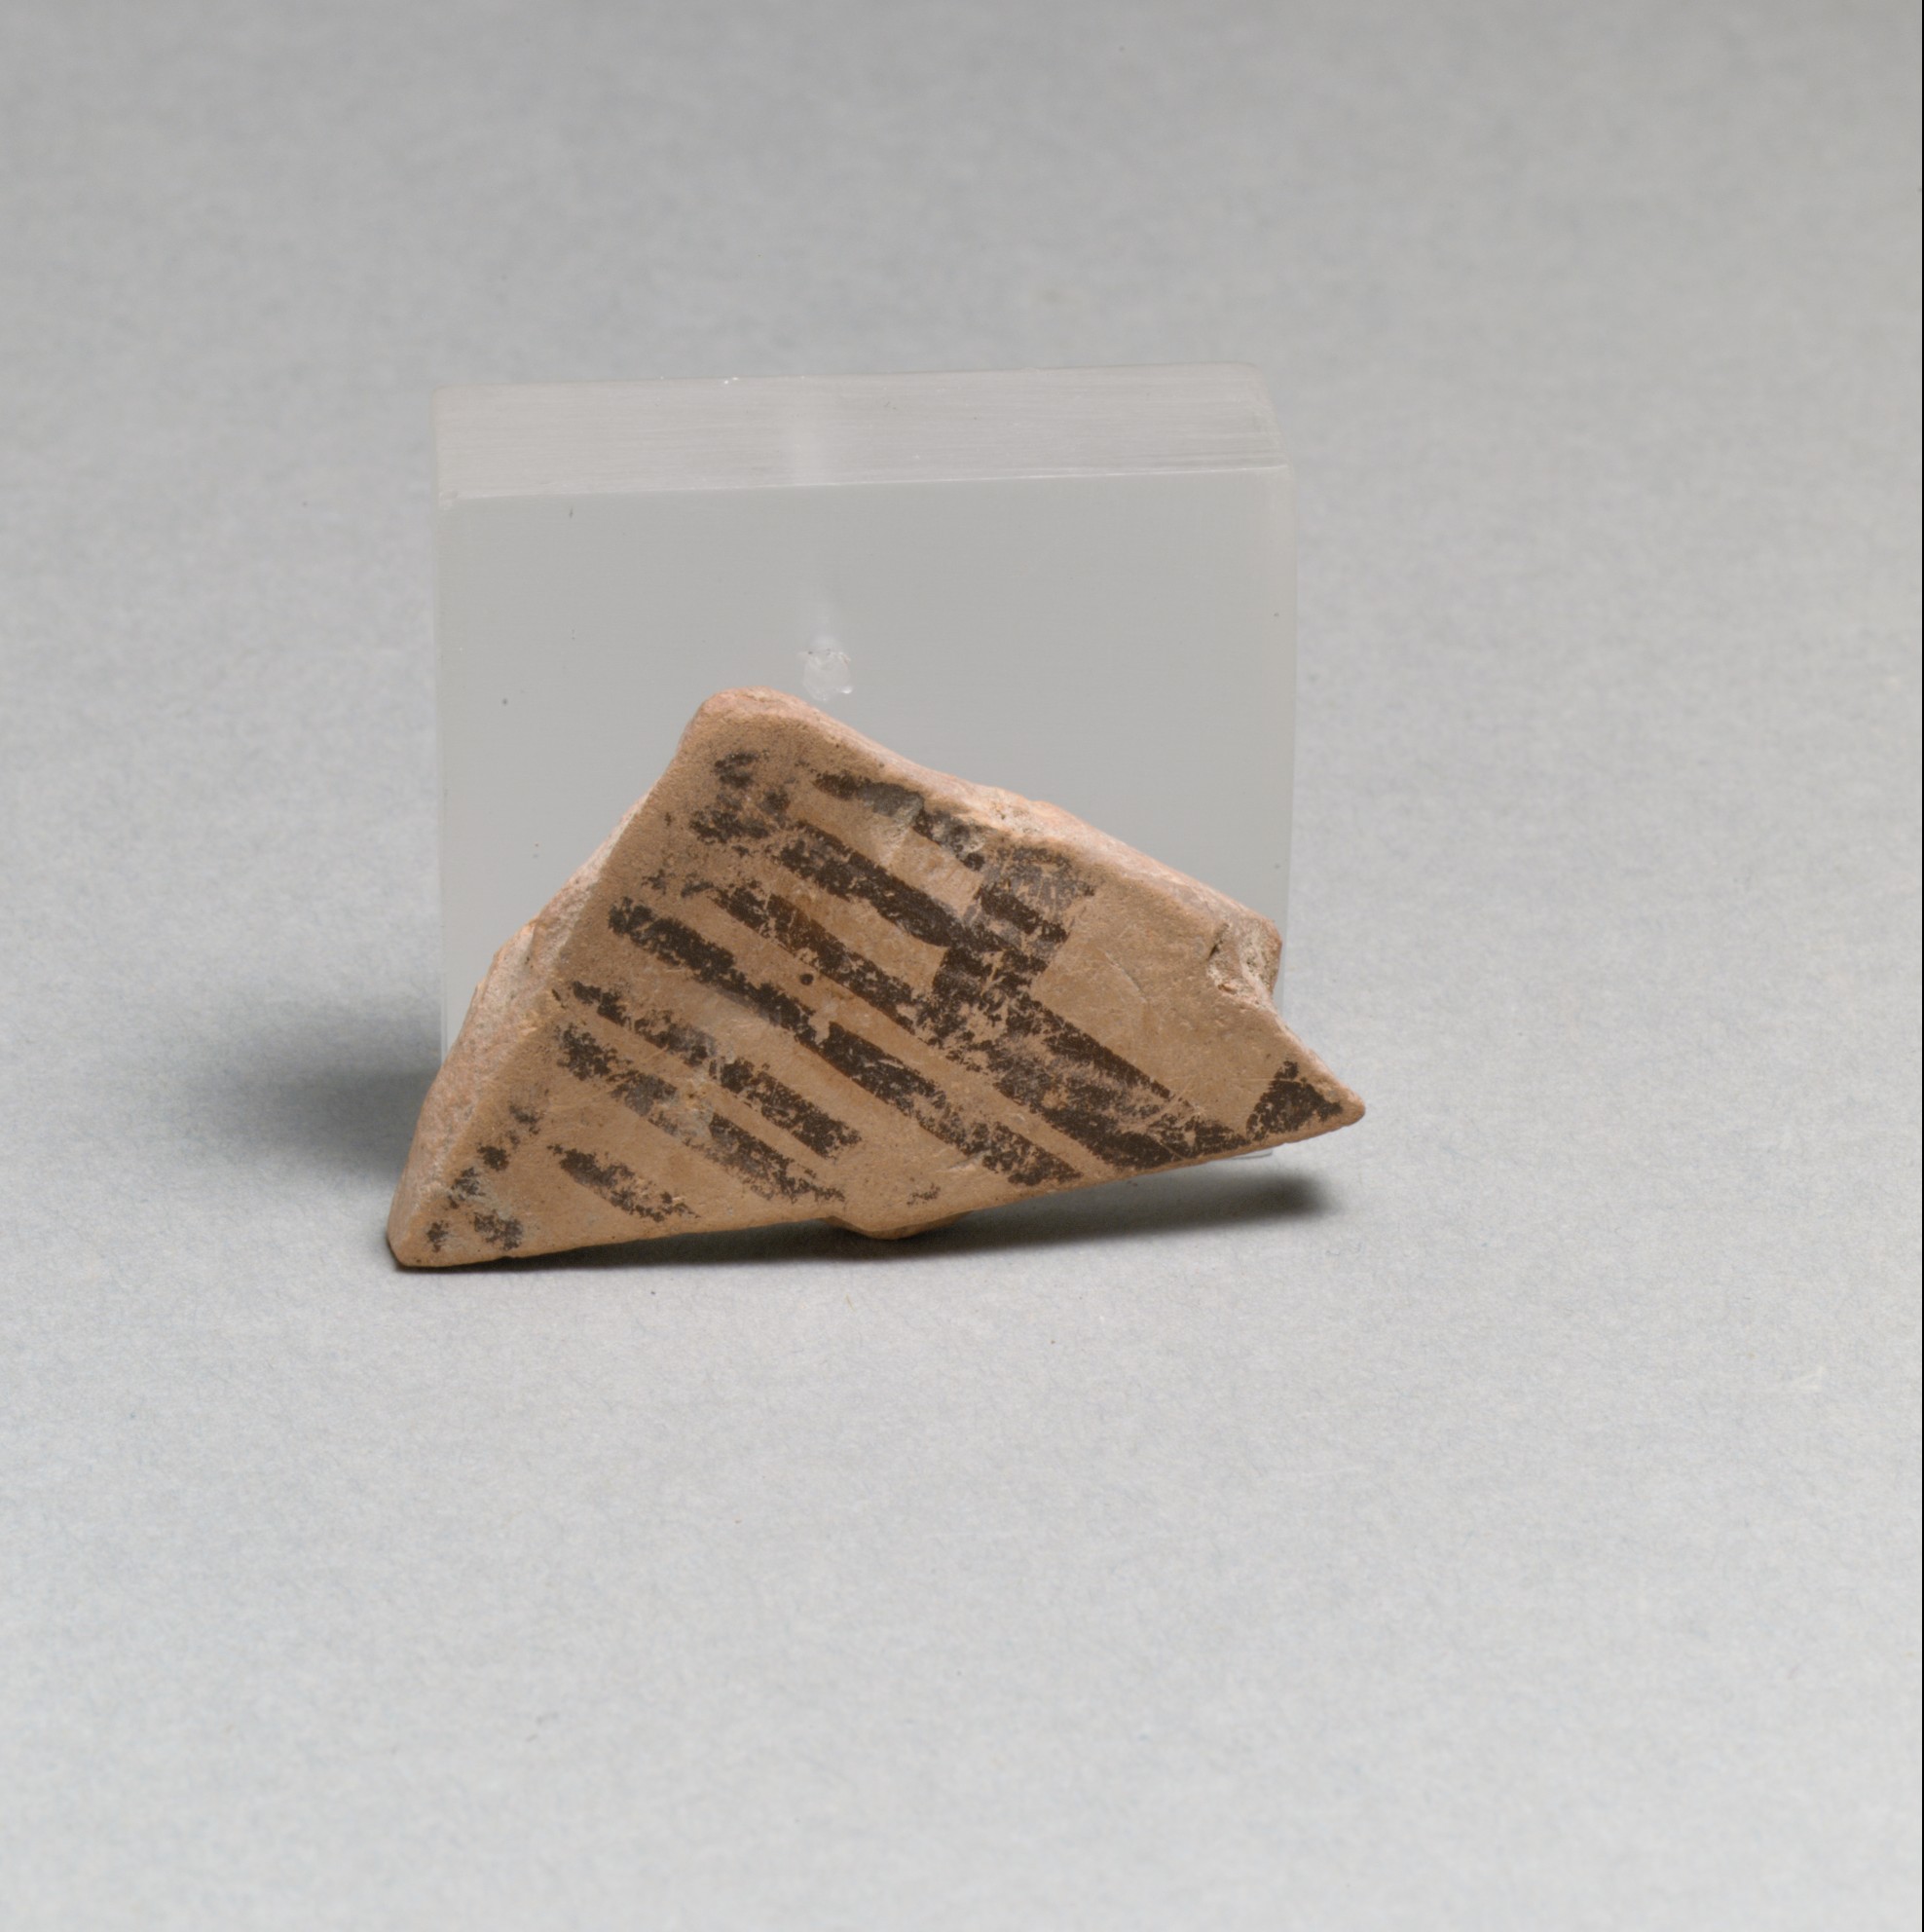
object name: vase fragment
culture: neolithic, thessaly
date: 4000-3000 BCE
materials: terracotta